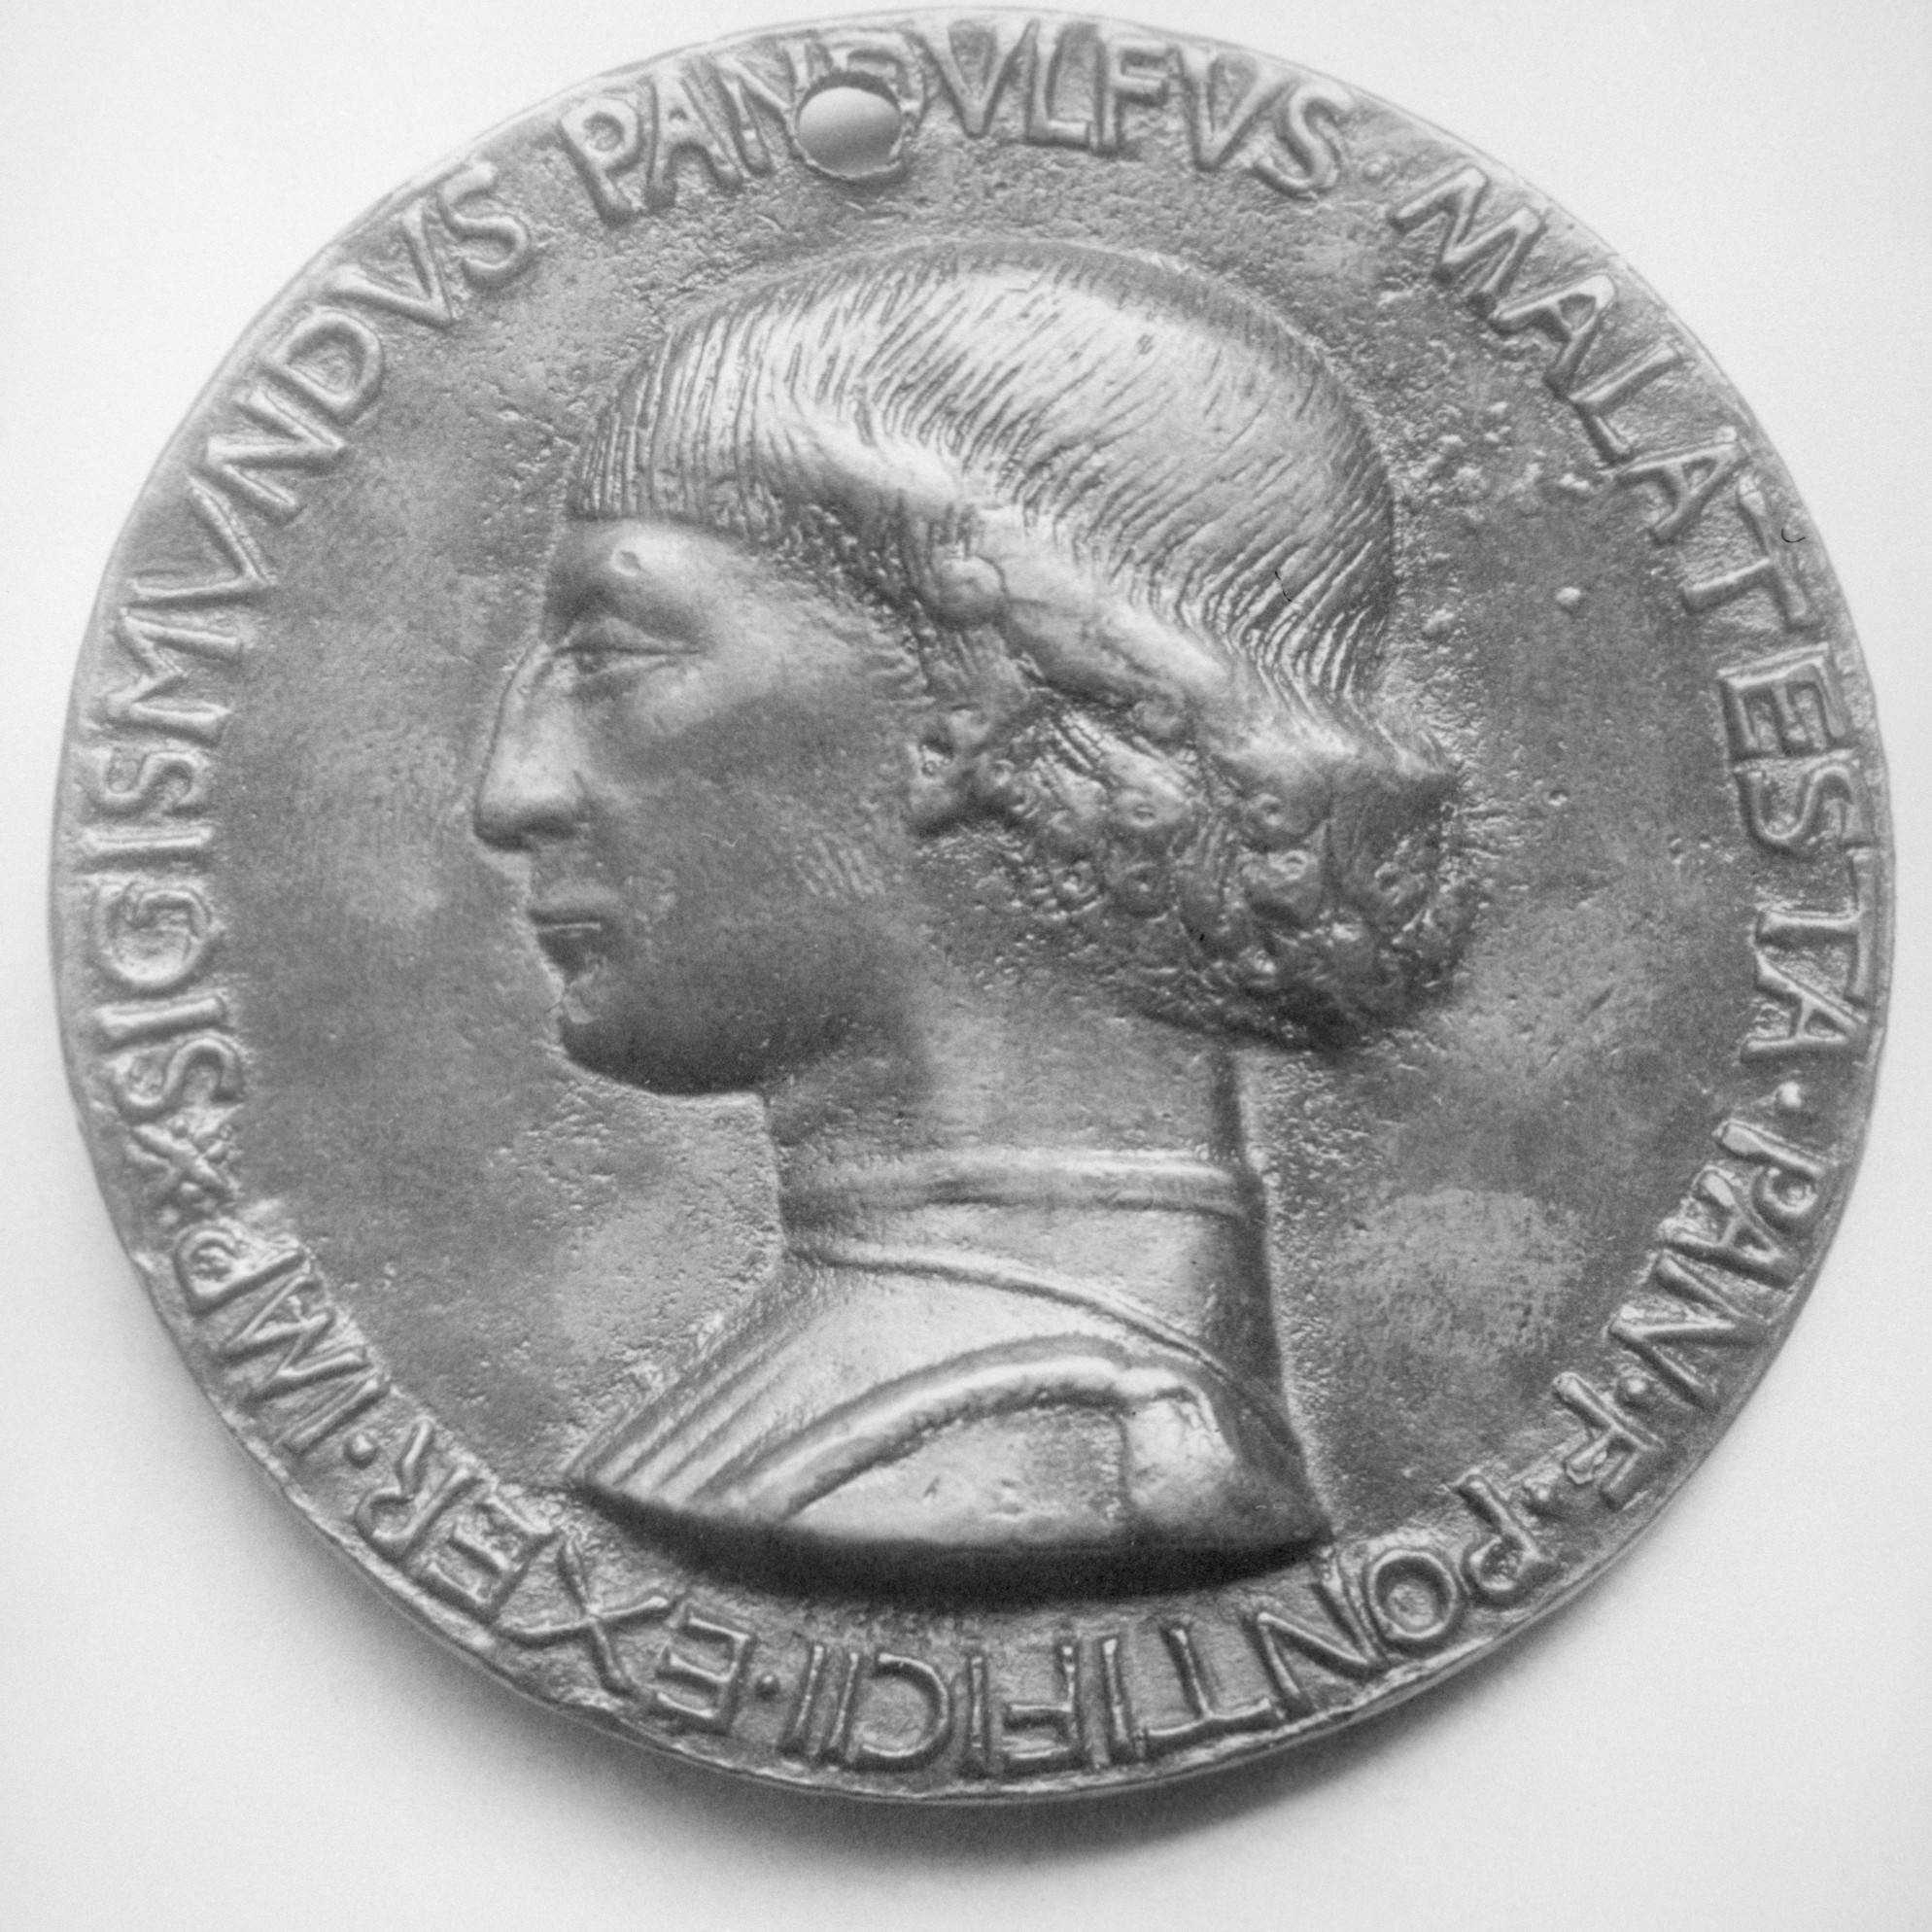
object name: medal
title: Sigismondo Pandolfo Malatesta, Lord of Rimini (1417–1468)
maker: matteo de' pasti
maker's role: artist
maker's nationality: italian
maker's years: 1420-1467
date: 1446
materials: bronze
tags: men,profiles,elephants